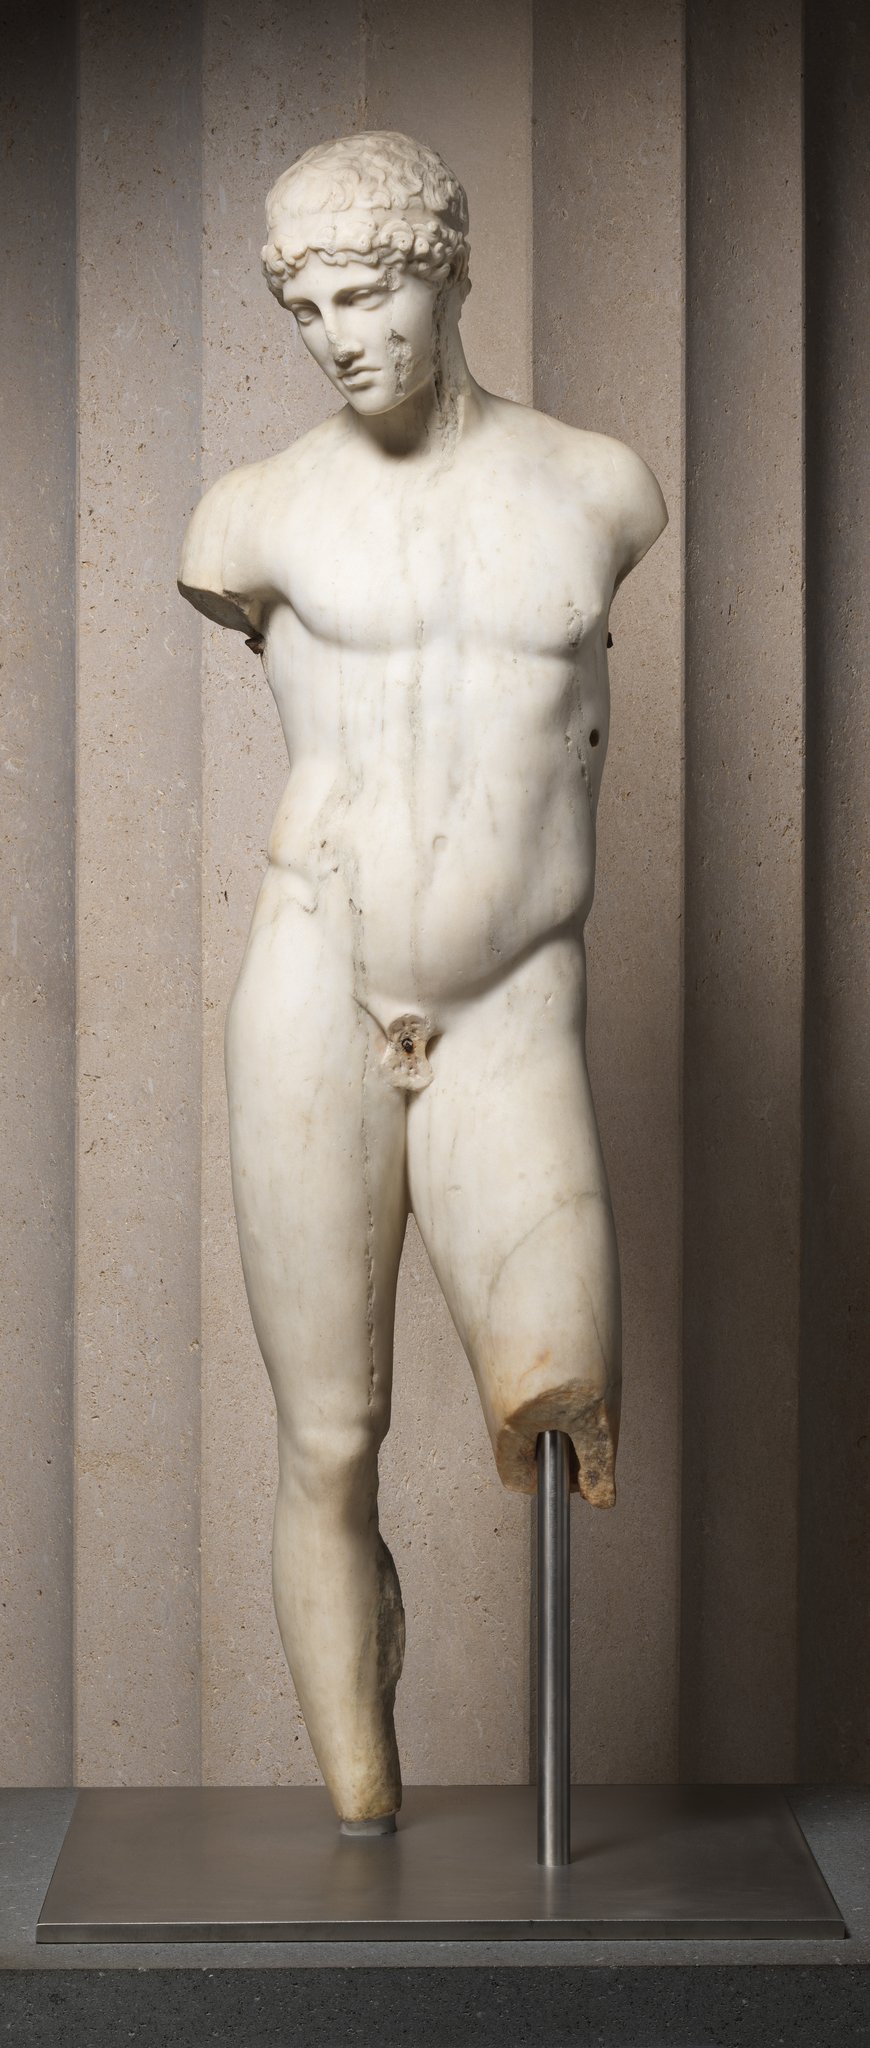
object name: statue of a youth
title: Marble statue of a youth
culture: roman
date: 1-100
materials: marble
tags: male nudes